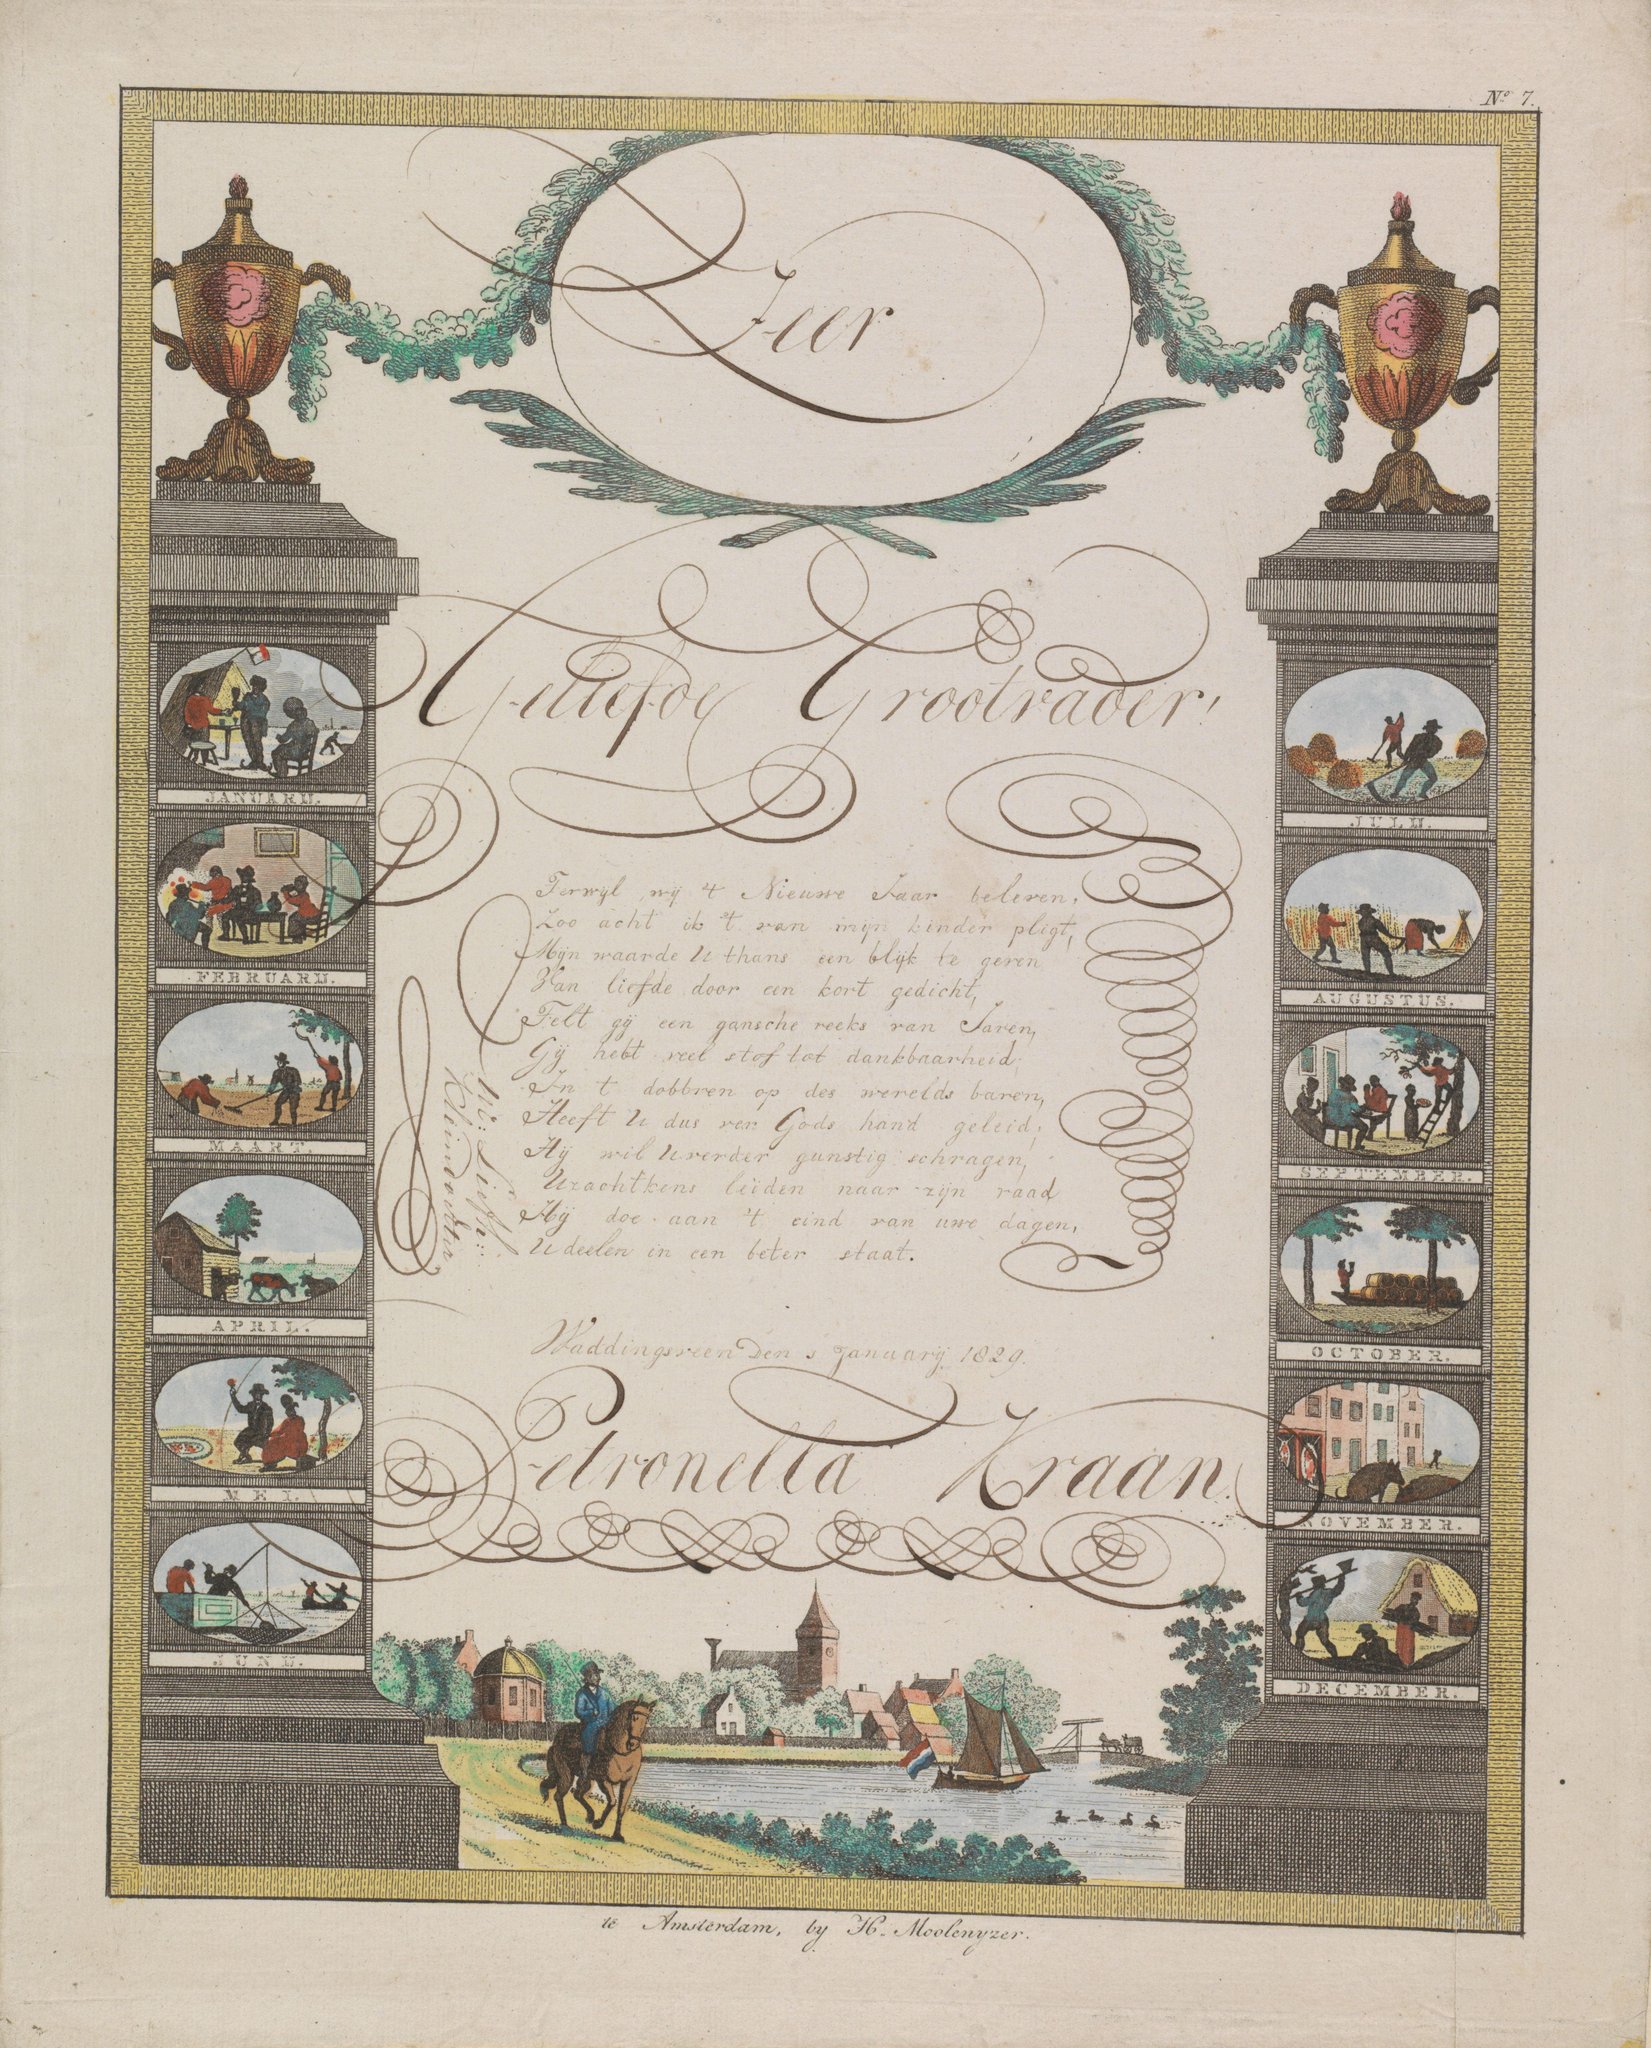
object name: print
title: Wensbrief met twaalf maanden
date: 1792-1847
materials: ink, paper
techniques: calligraphy, colour, etching, pen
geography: amsterdam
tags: the twelve months represented by scenes showing human activities, usually in a landscape; so-called 'labours of the months'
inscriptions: inscription: ‘Zeer / Geliefde grootvader! / Terwijl wij 't nieuwe jaar beleven ...’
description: Wensbrief met beschreven cartouche binnen een decoratief kader met voorstellingen van de twaalf maanden van het jaar en de bijbehorende activiteiten. Handgeschreven bericht in kalligrafie (Nieuwjaarswens) door Petronella Kraan aan haar grootvader. Genummerd rechtsboven: No. 7.